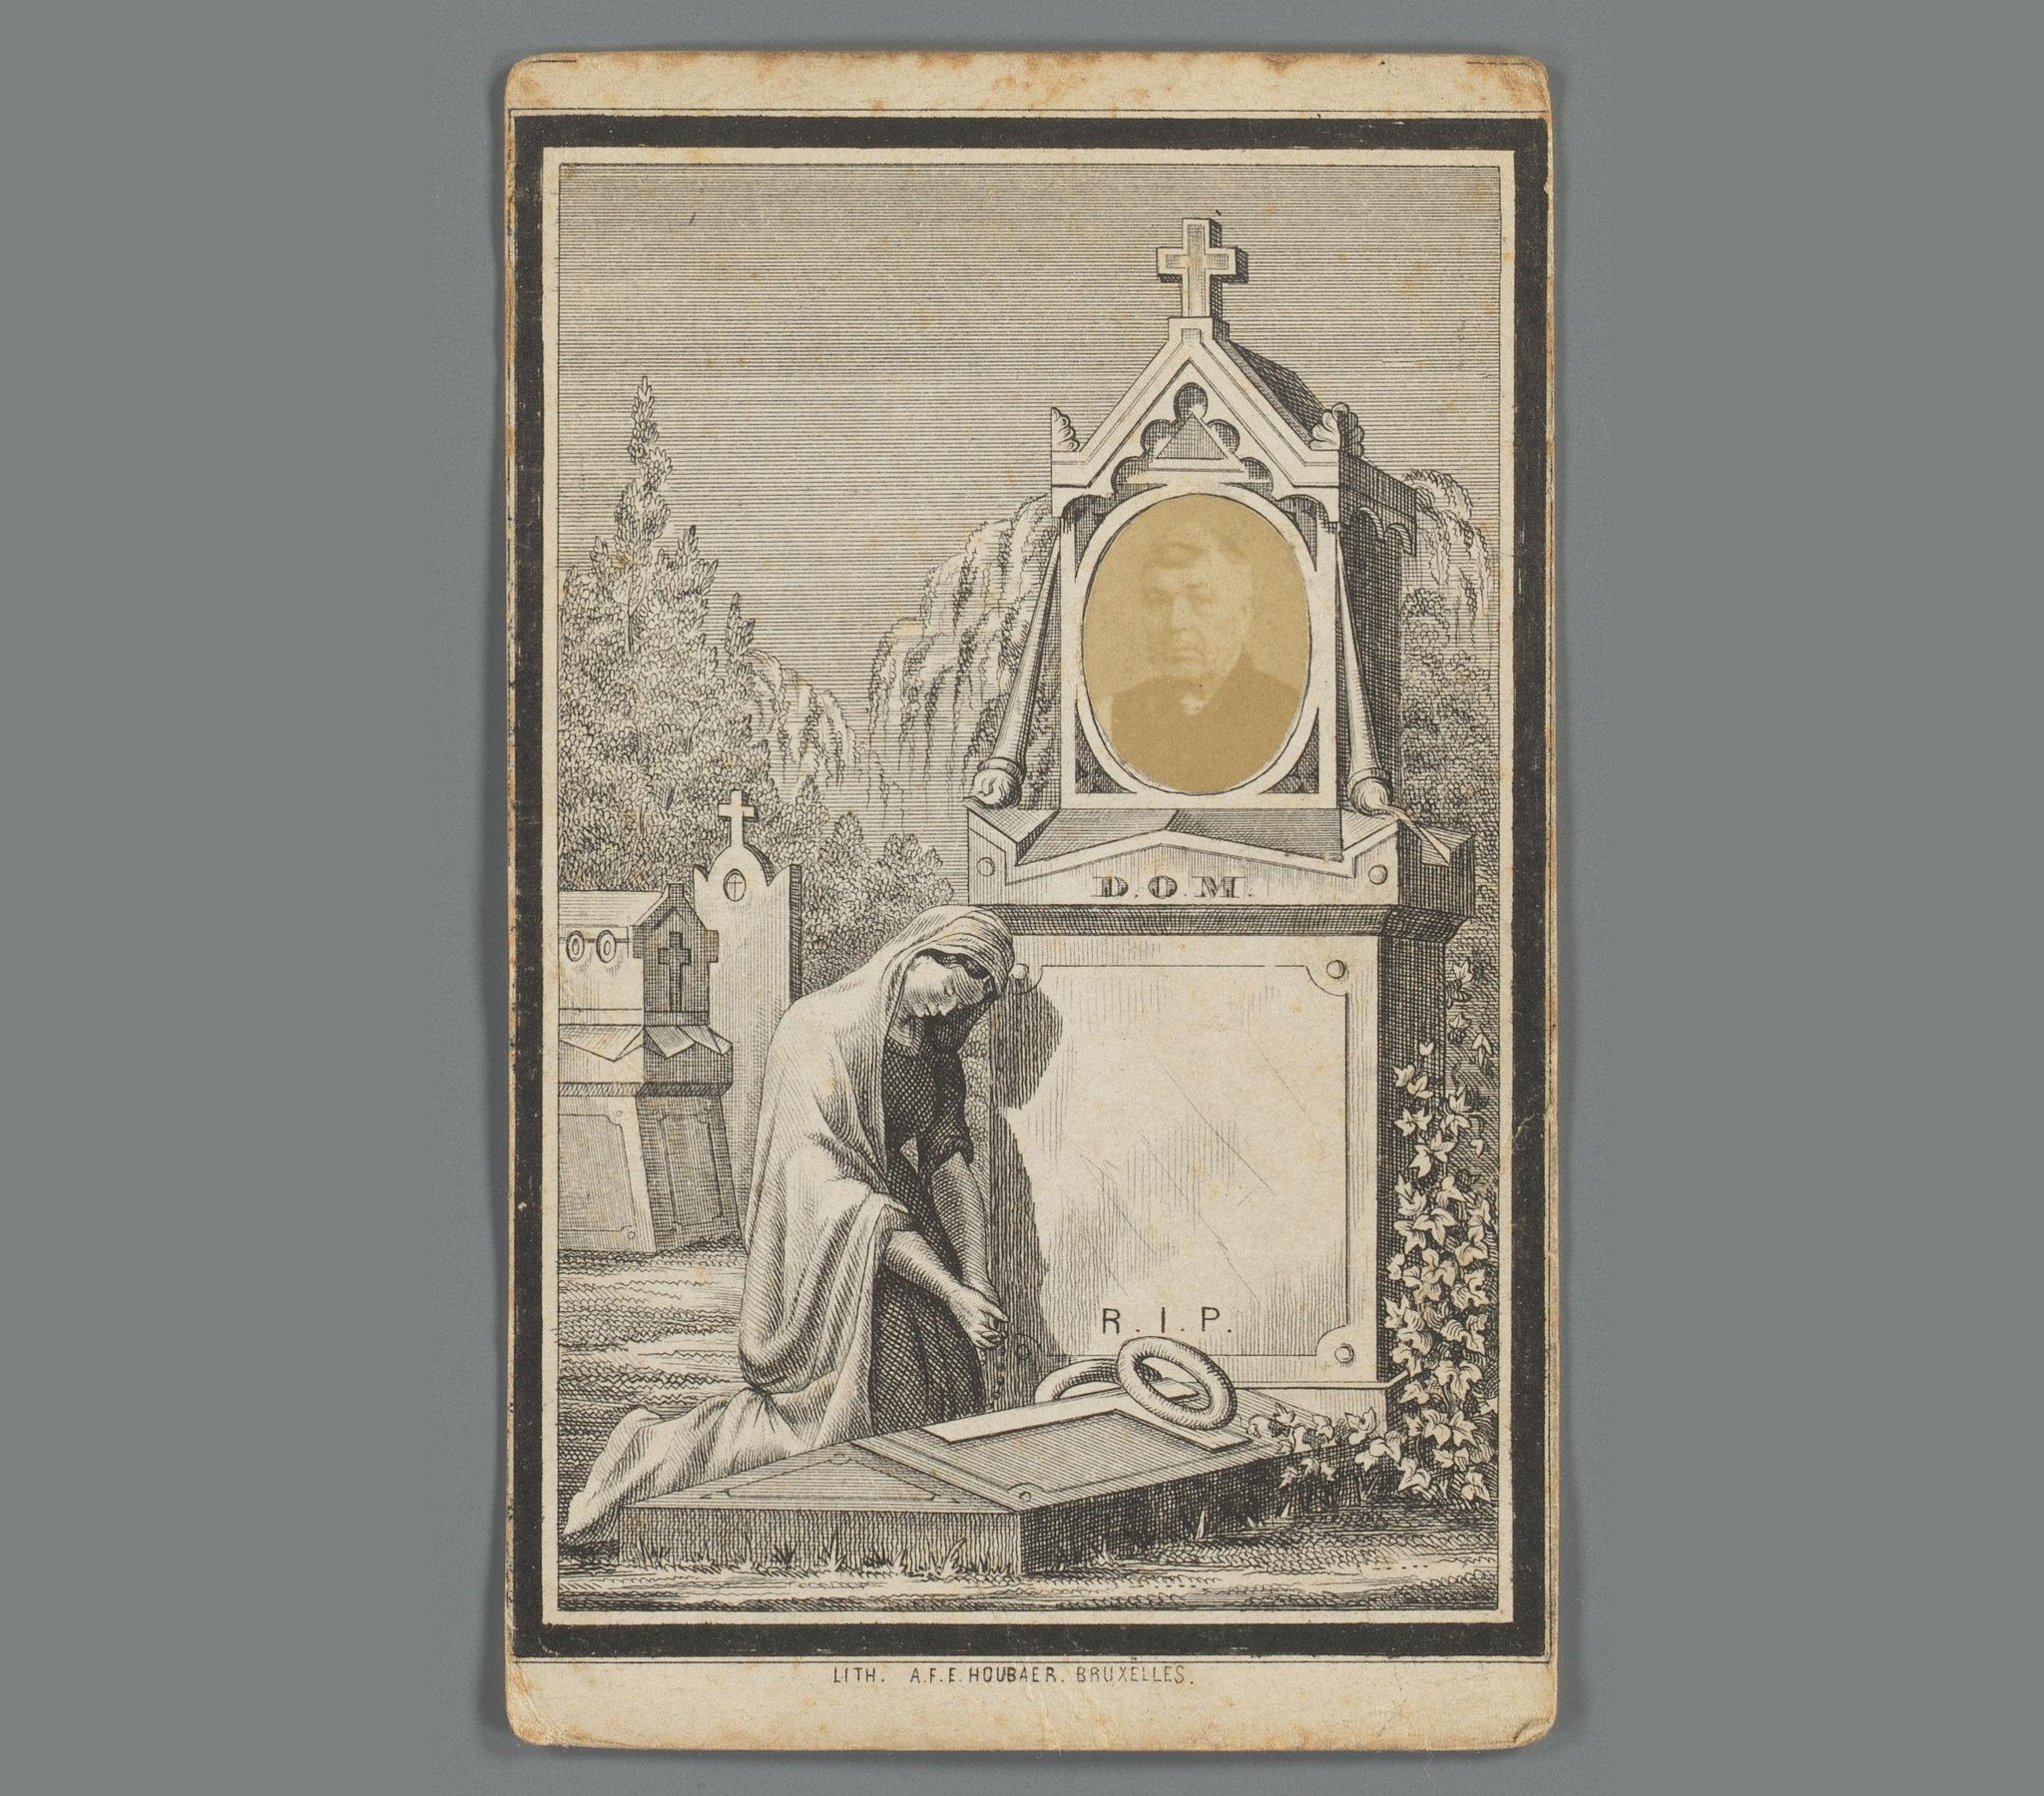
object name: prayer card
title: Portret van Petrus Houbaer op een grafzerk met rouwende vrouw, op bidprent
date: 1874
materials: paper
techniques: albumen print, letterpress printing, lithograph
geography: brussels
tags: bergen op zoom, adult man, historical persons, mourning customs, gravestone, tombstone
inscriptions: inscription: ‘Lith. A.F.E. Houbaer. Bruxelles.’, inscription: ‘Bid voor de Ziel van Zaliger/ den Heer (...) R.I.P.’